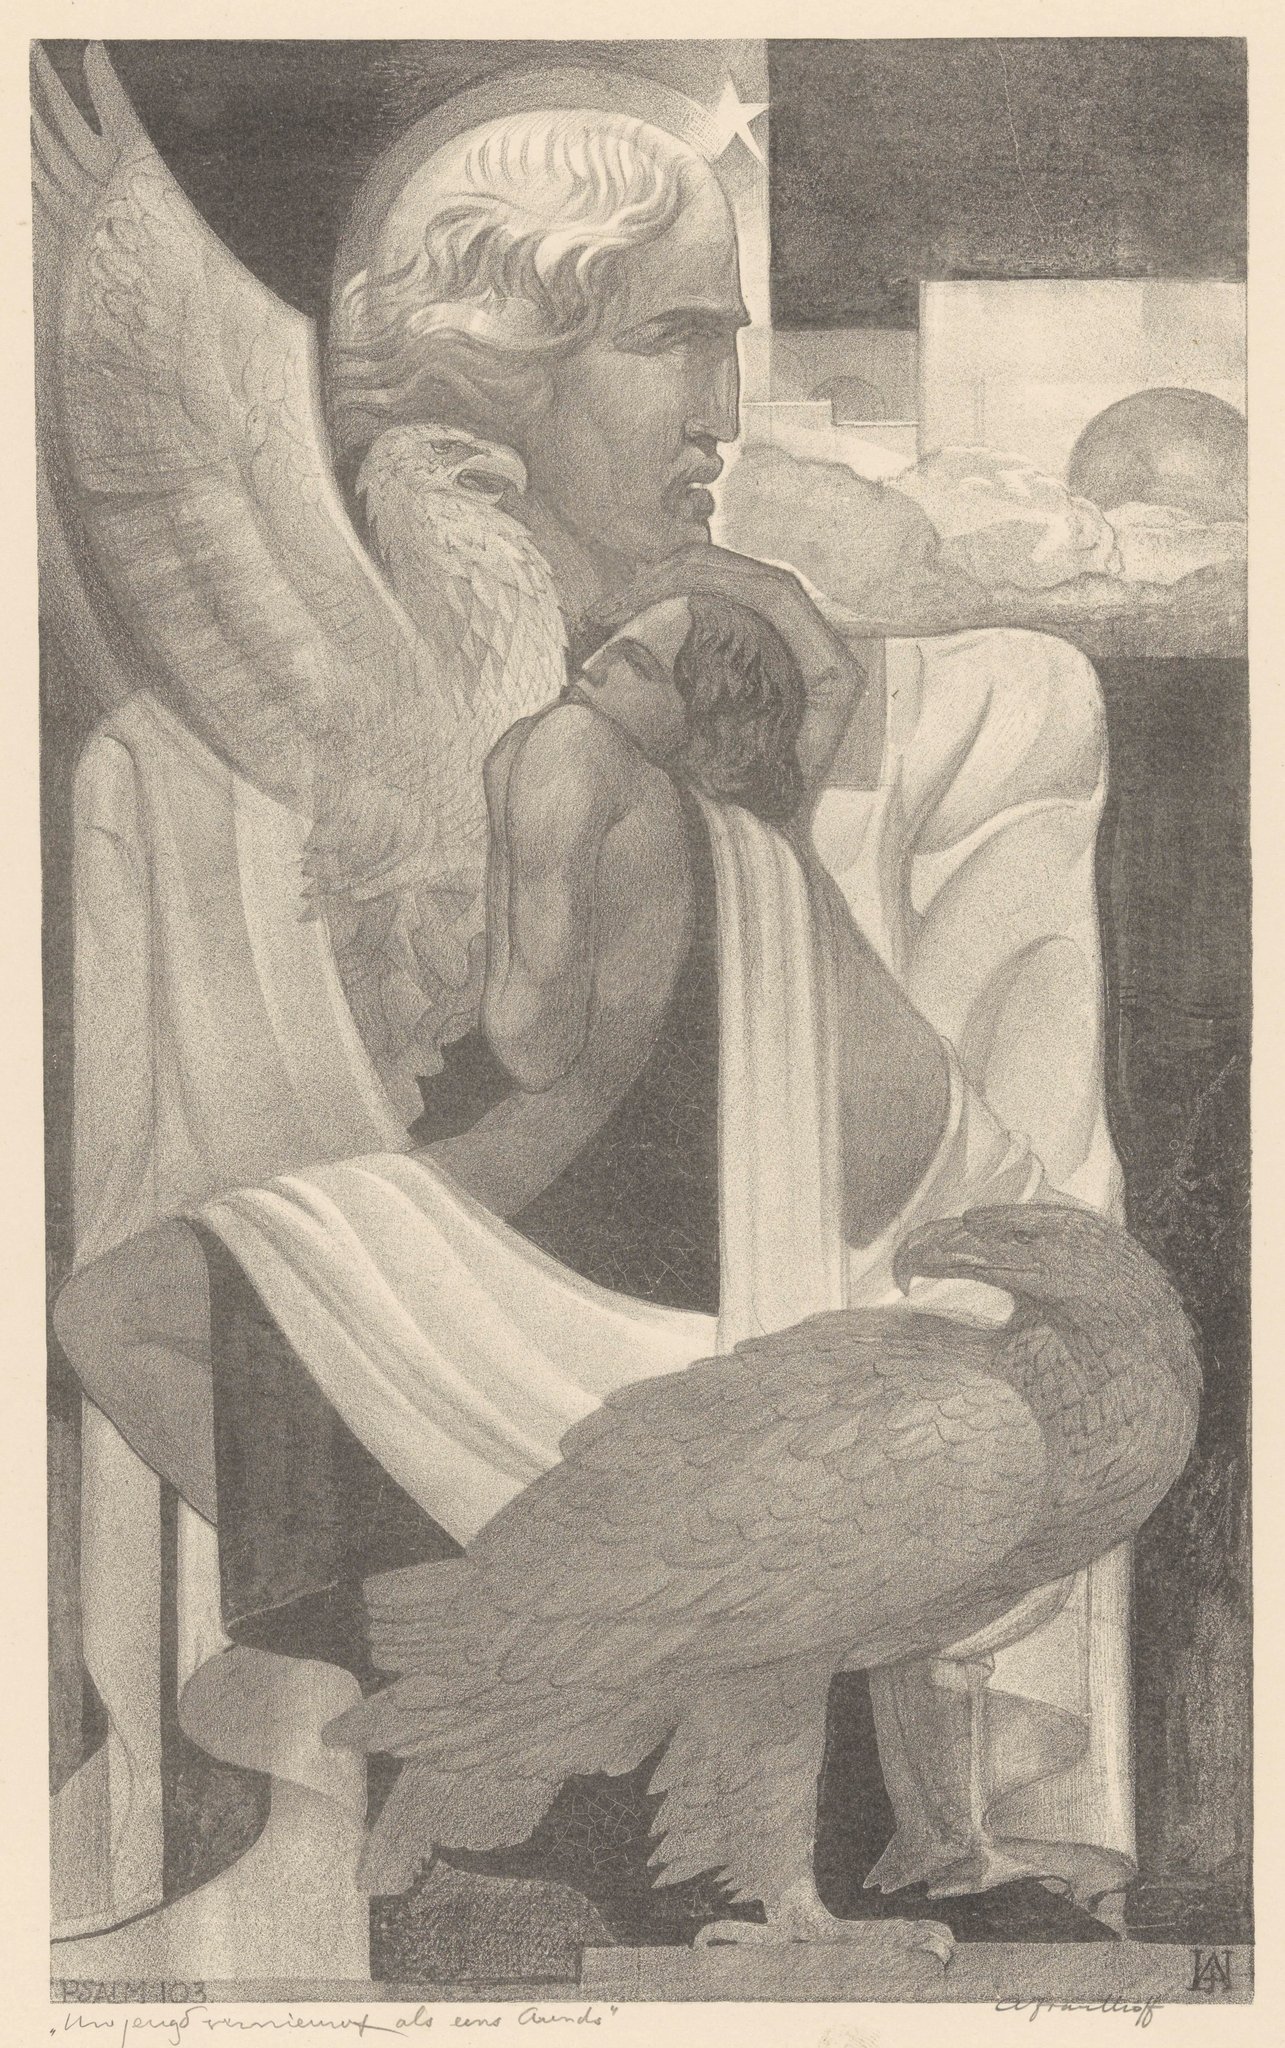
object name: print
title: Uw jeugd vernieuwt als eens arends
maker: adriaan j. van t hoff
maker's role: draughtsman, print maker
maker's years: 1893-1939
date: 1908-1932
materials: paper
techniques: lithograph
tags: predatory birds: eagle, the book of psalms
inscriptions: collector's mark: Lugt 2228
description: Een grote man legt zijn linkerhand op het hoofd van een kleinere figuur die in elkaar gedoken voor hem zit. Links een arend met gespreide vleugels; op de voorgrond een zittende arend. Linksonder de tekst: Psalm 103.